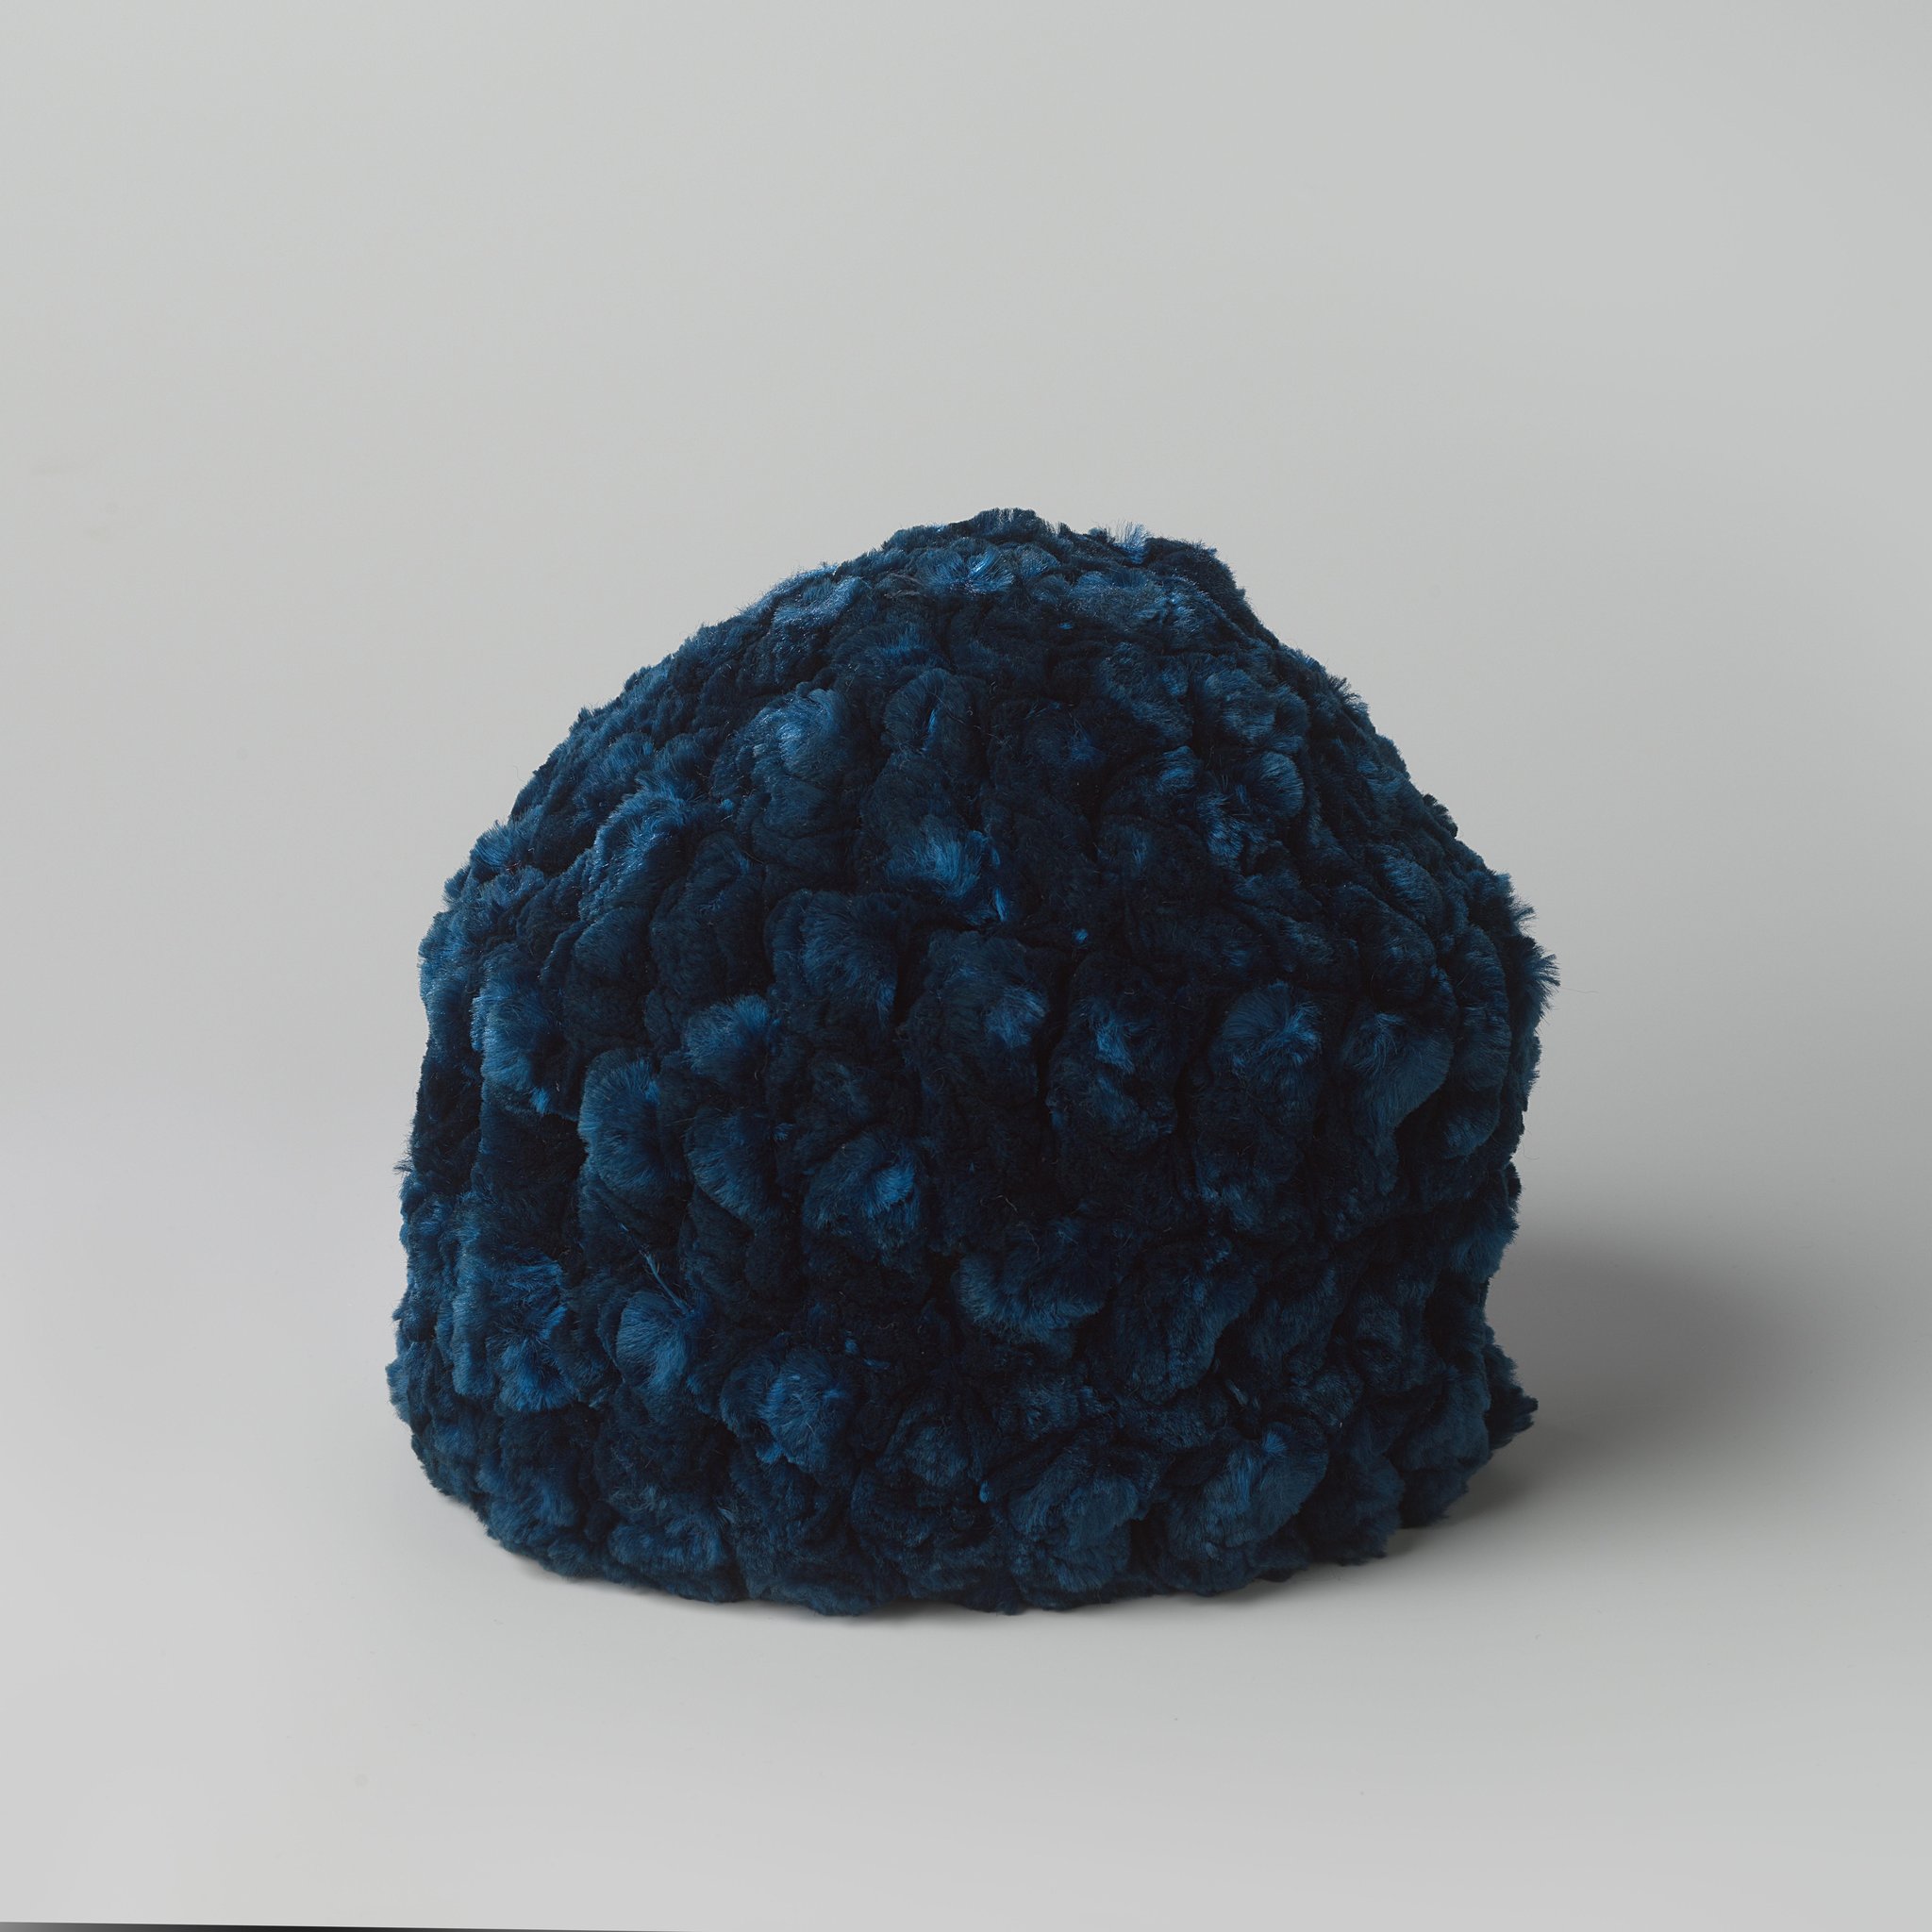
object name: womenswear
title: Muts van blauwe chenille, puntig model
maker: christian dior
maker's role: modeontwerper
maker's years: 1905-1957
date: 1958-1962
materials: textile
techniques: weave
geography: paris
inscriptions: name: ‘Christian Dior/ Paris/ Made in France’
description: Muts van blauwe chenille, puntig model. Binnenwerk van donkerblauwe tulle grecque. Donkerblauwe hoedband.